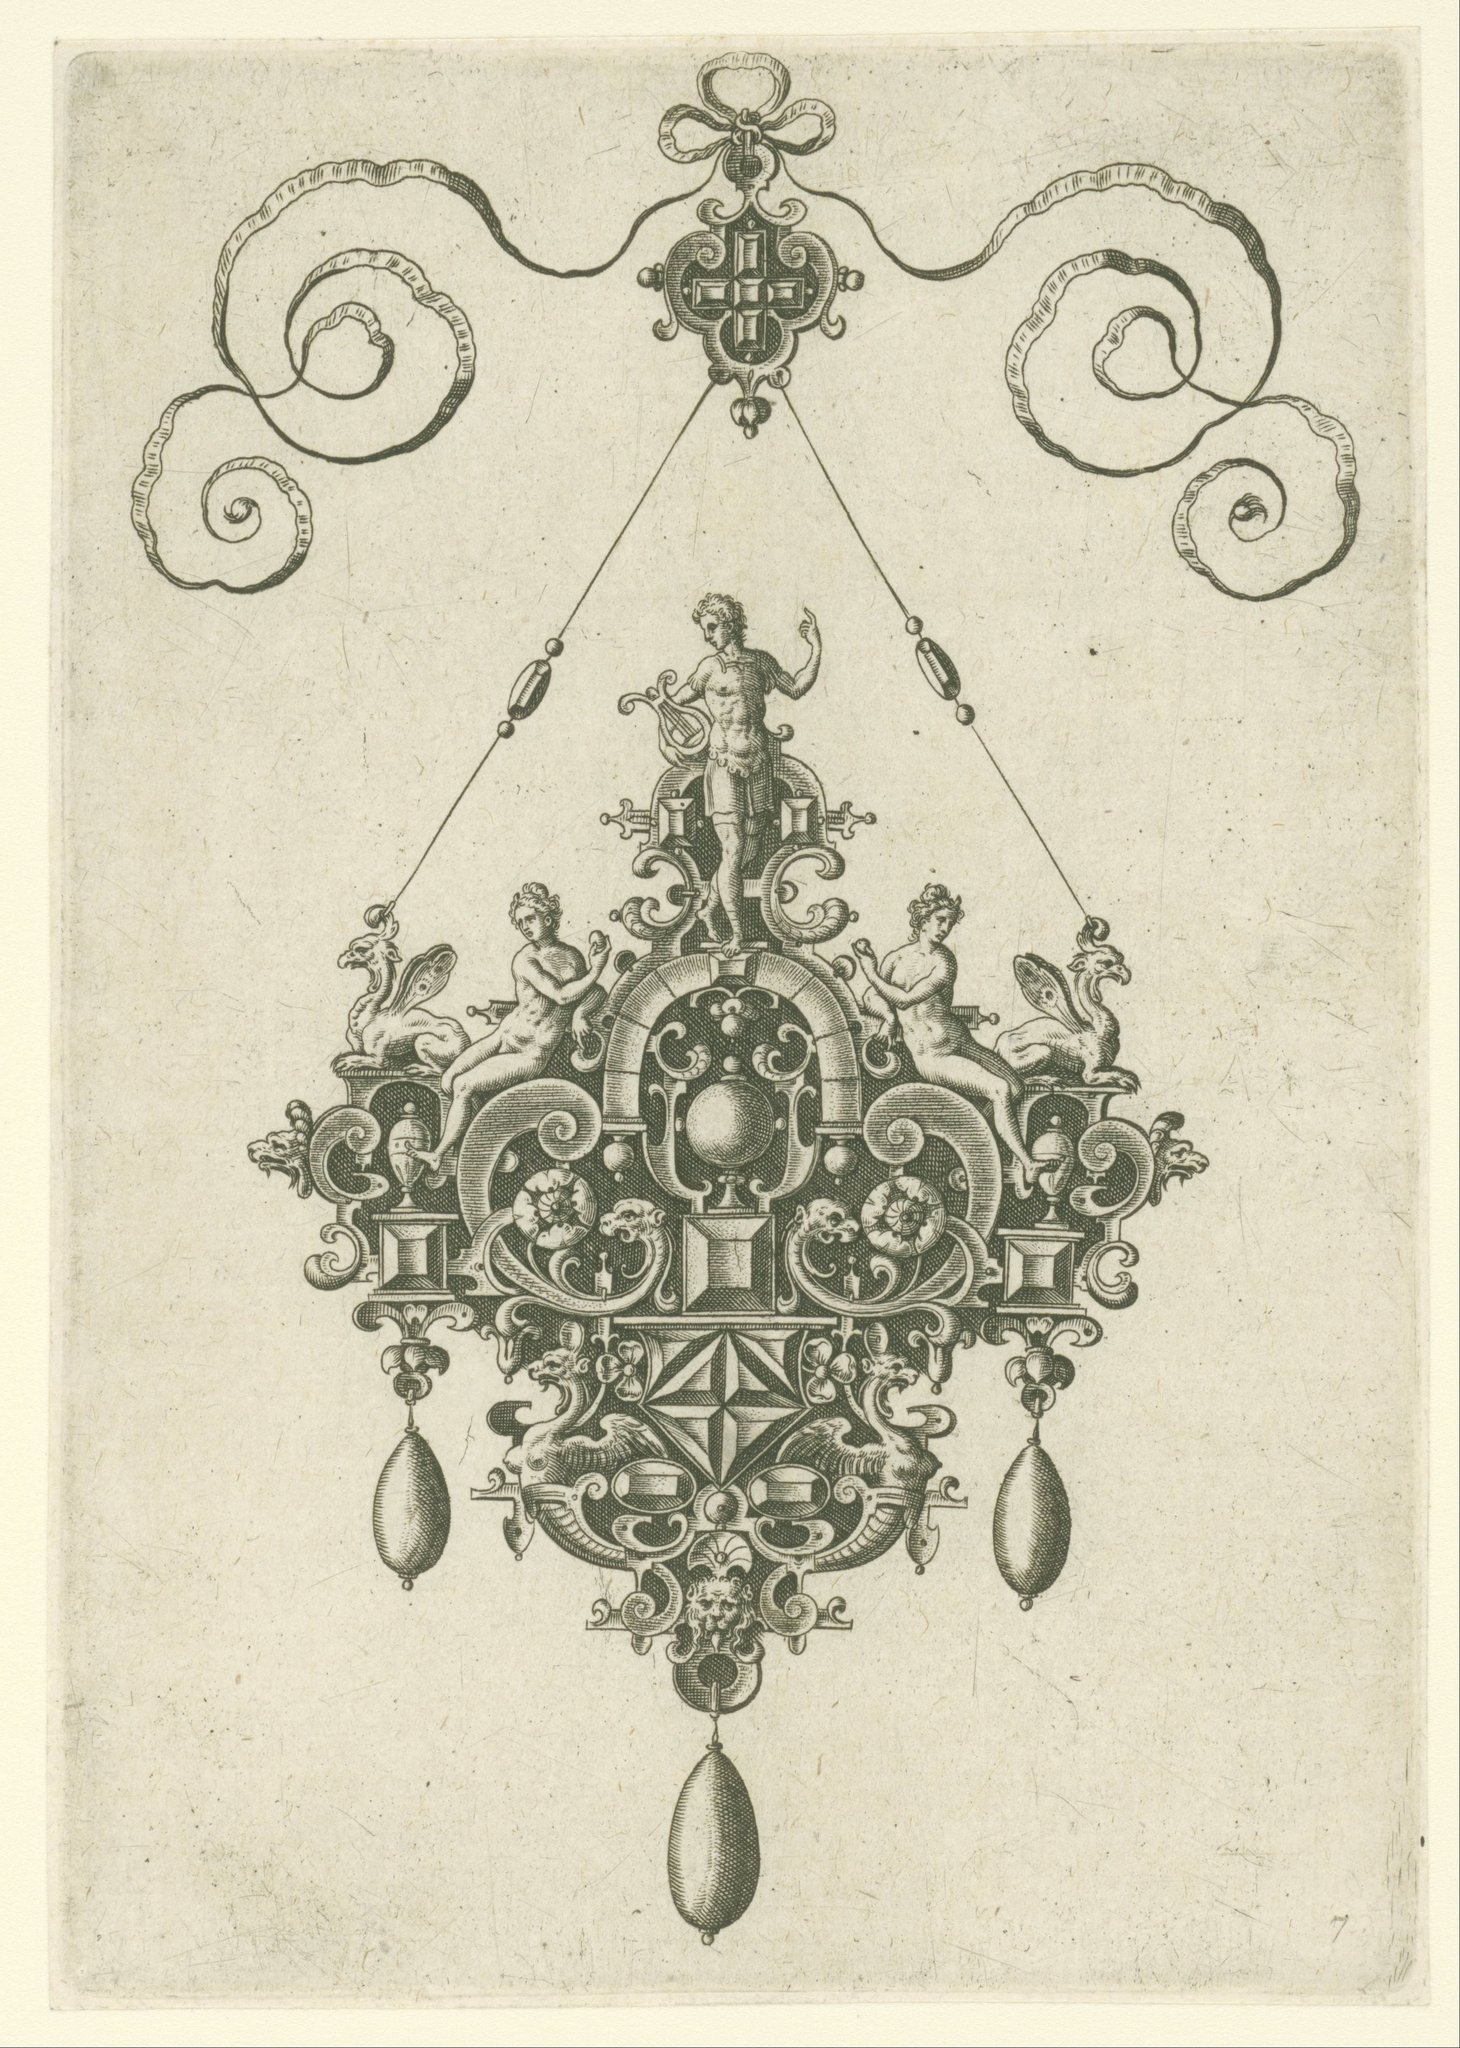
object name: ornament print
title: Hanger met Apollo met zijn lier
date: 1581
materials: paper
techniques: engraving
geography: netherlands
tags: (story of) apollo (phoebus), pendant, trinket, 'breloque'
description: No. 7 uit serie van 10 bladen met ornamentontwerpen, Antwerpen 1581. W. 20